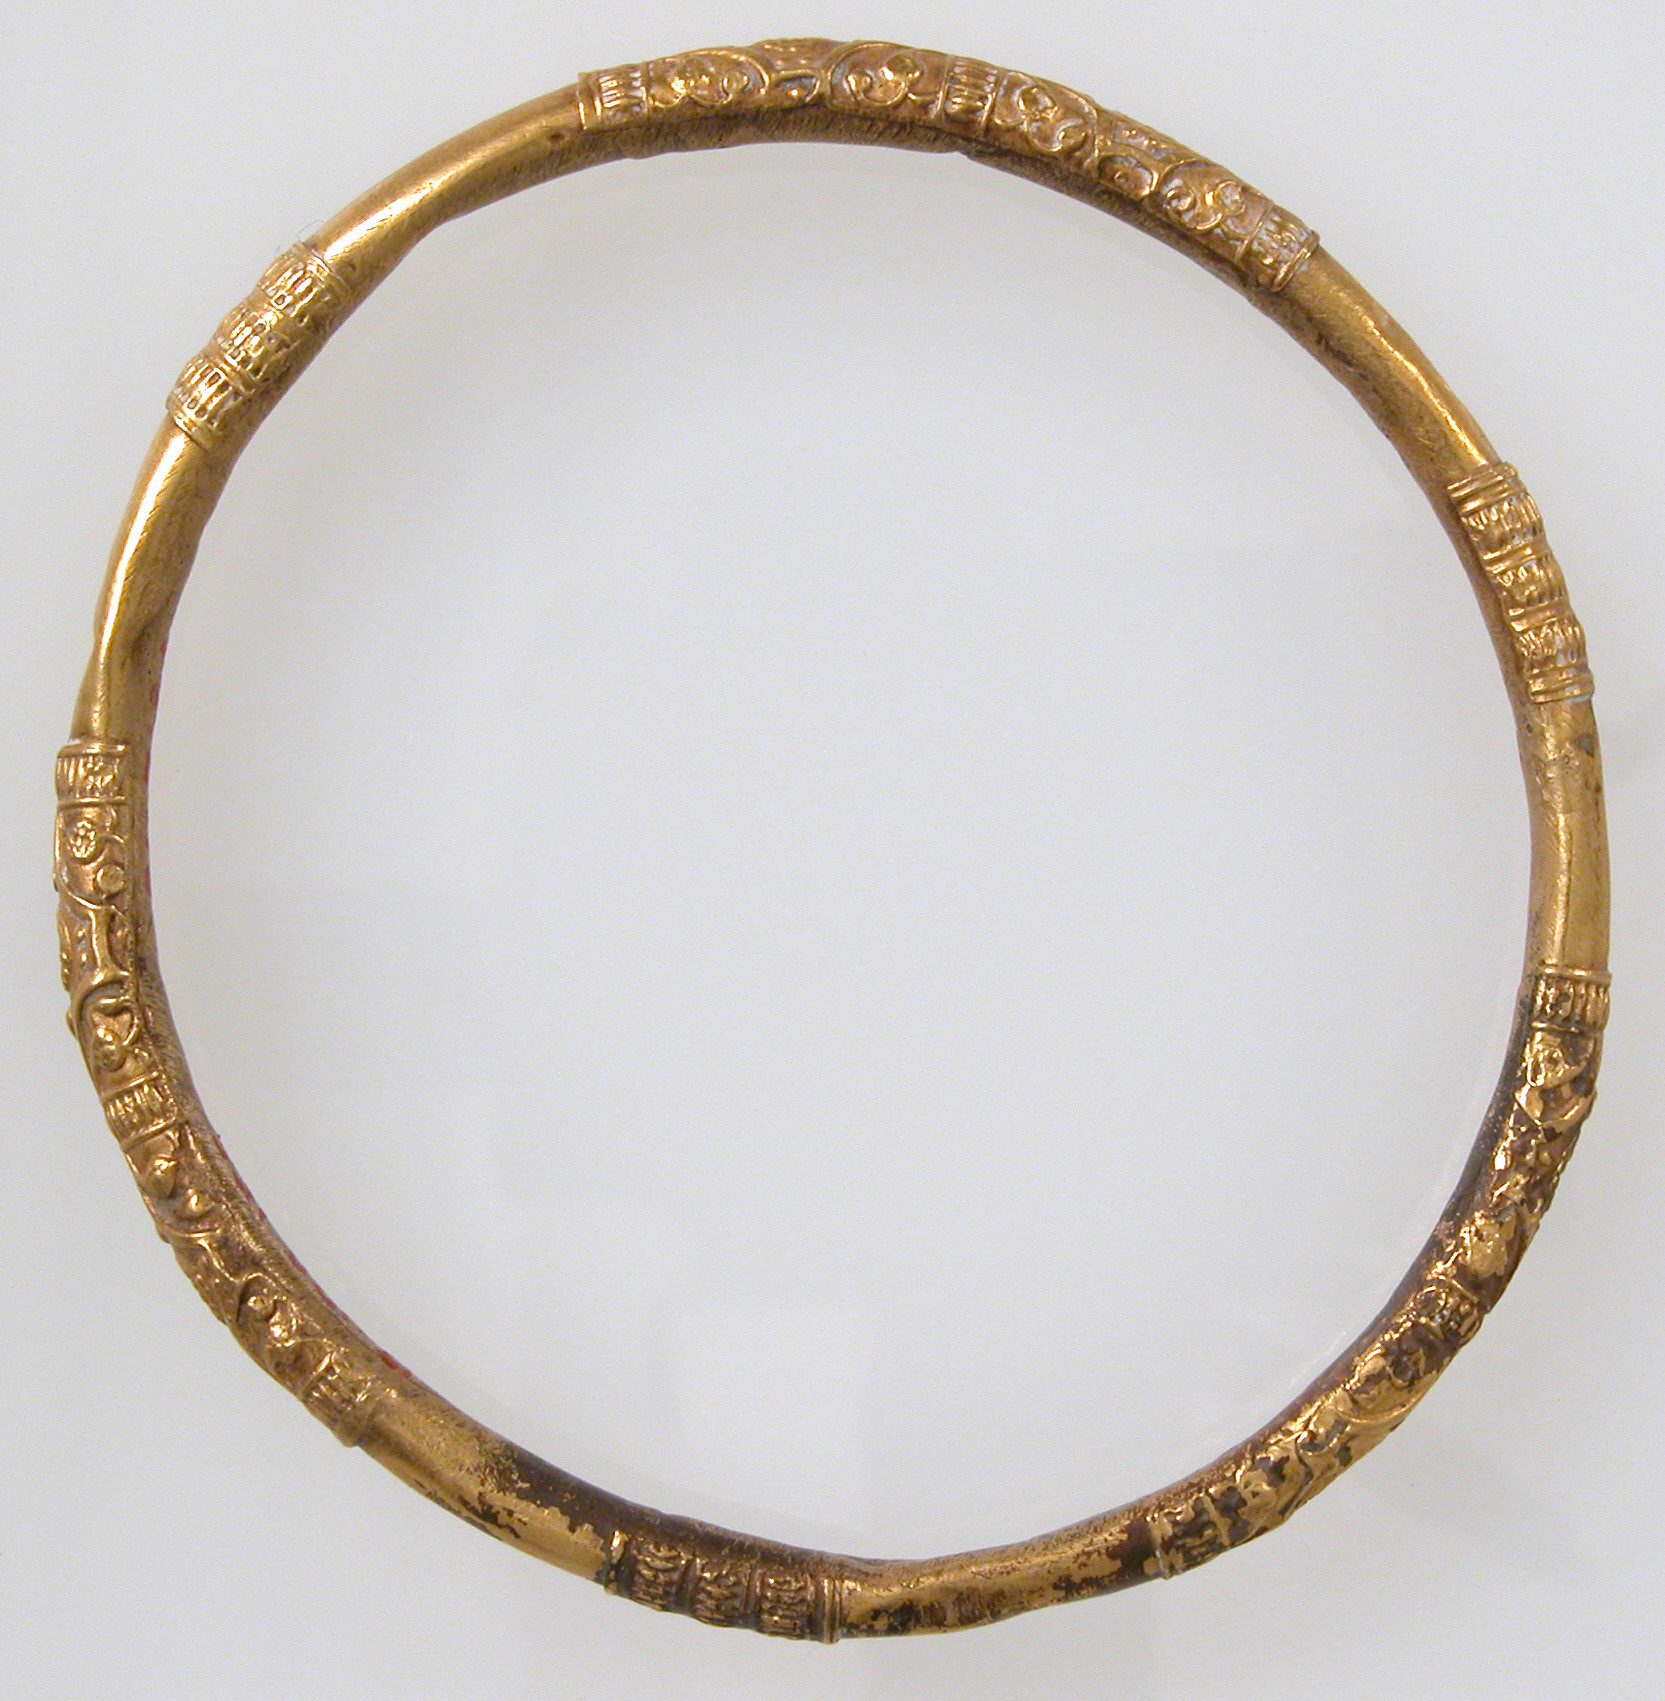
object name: bracelet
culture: spanish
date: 1501-1600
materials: gold